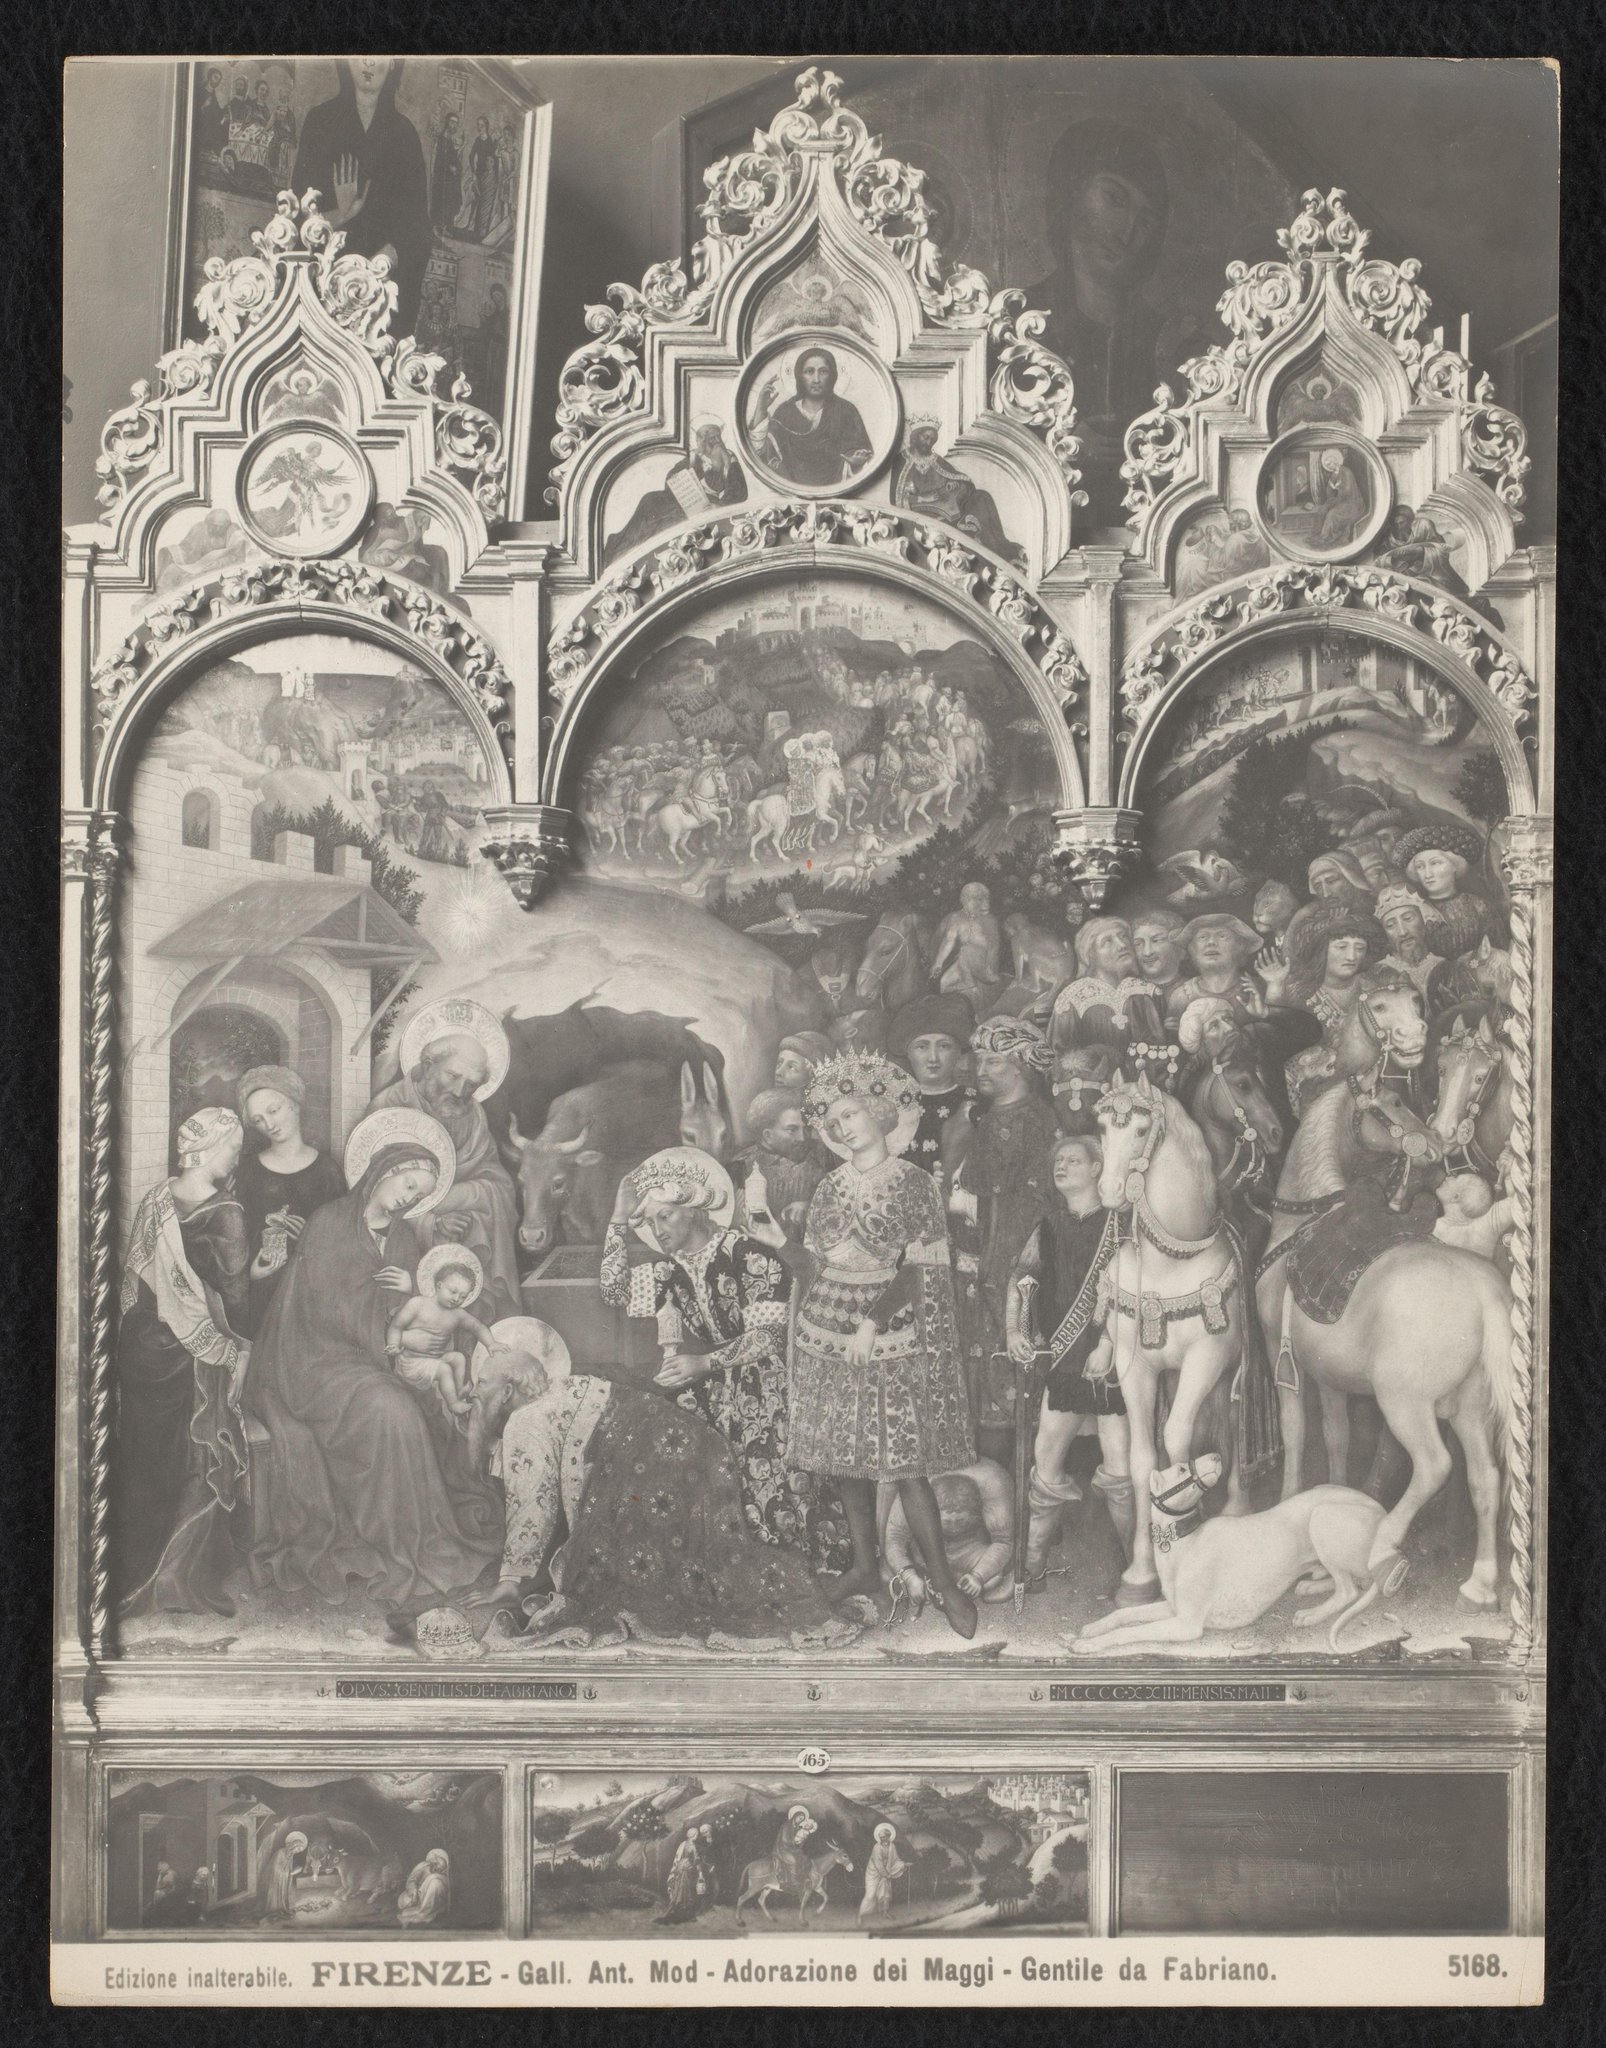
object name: reproduction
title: Firenze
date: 1901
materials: paper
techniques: gelatin silver print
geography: berlin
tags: picture, painting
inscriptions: inscription: ‘Edizione inalterabile.’, number: ‘5268.’, collector's mark: ‘RIJKS SCHOOL VOOR KUNSTNIJVERHEID/ GROEP’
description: Deze foto maakt deel uit van een omslag.